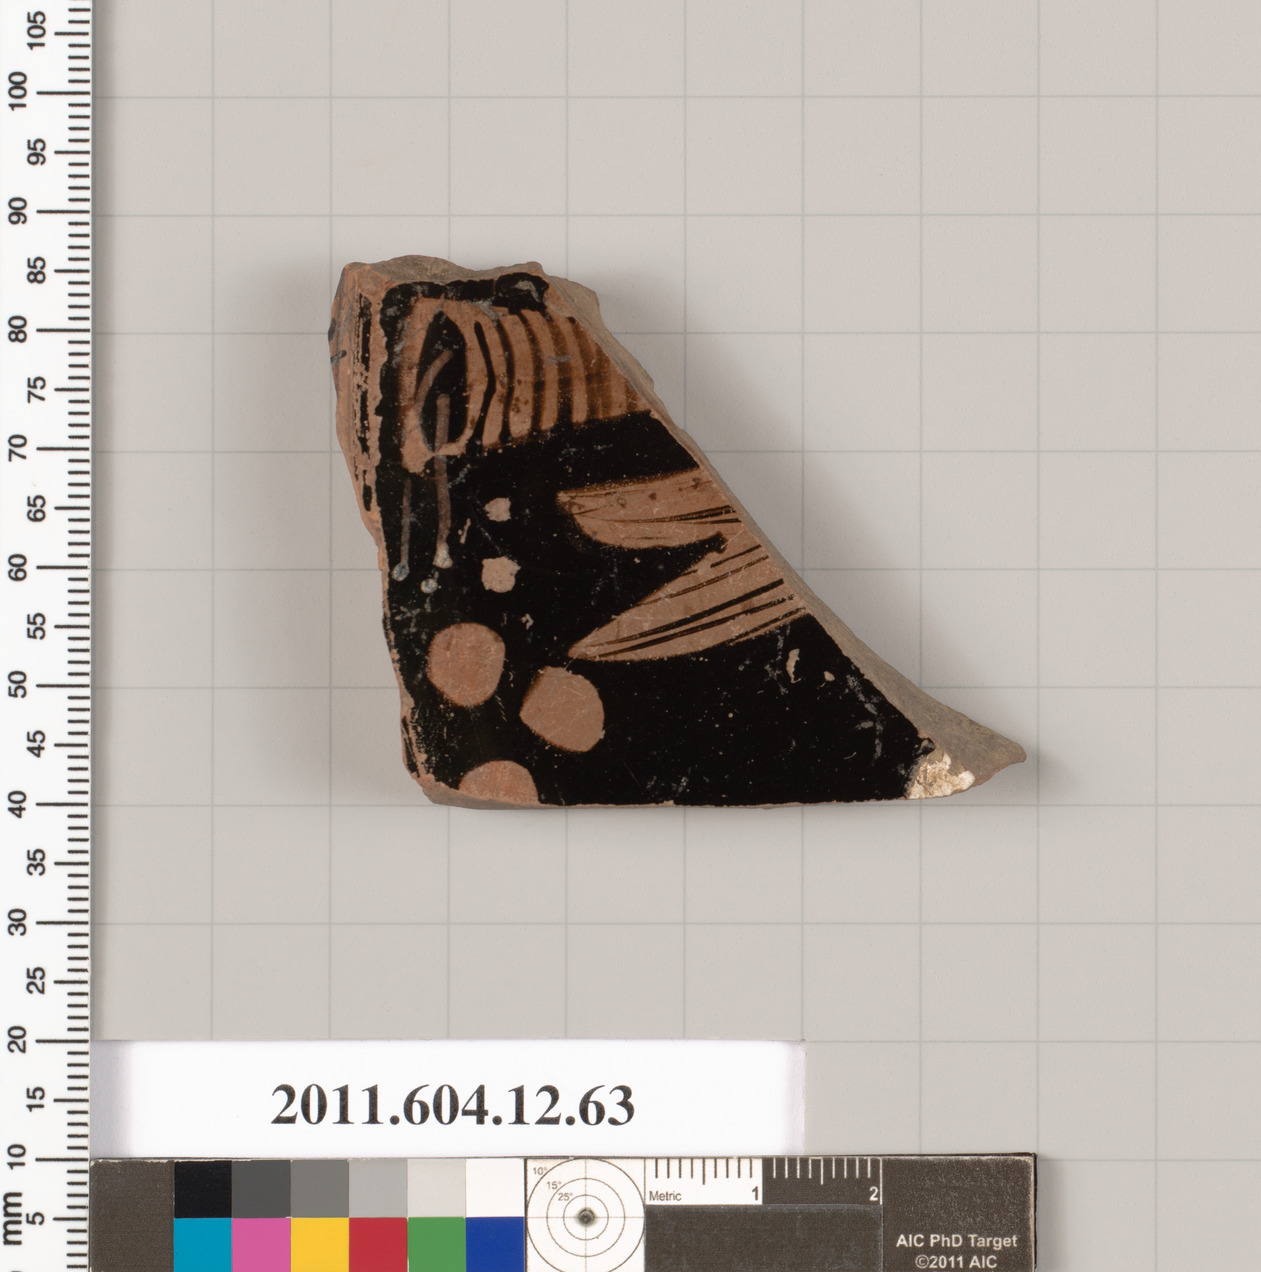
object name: fish plate fragment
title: Terracotta fragment of a fish plate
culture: greek or south italian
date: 400-301 BCE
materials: terracotta